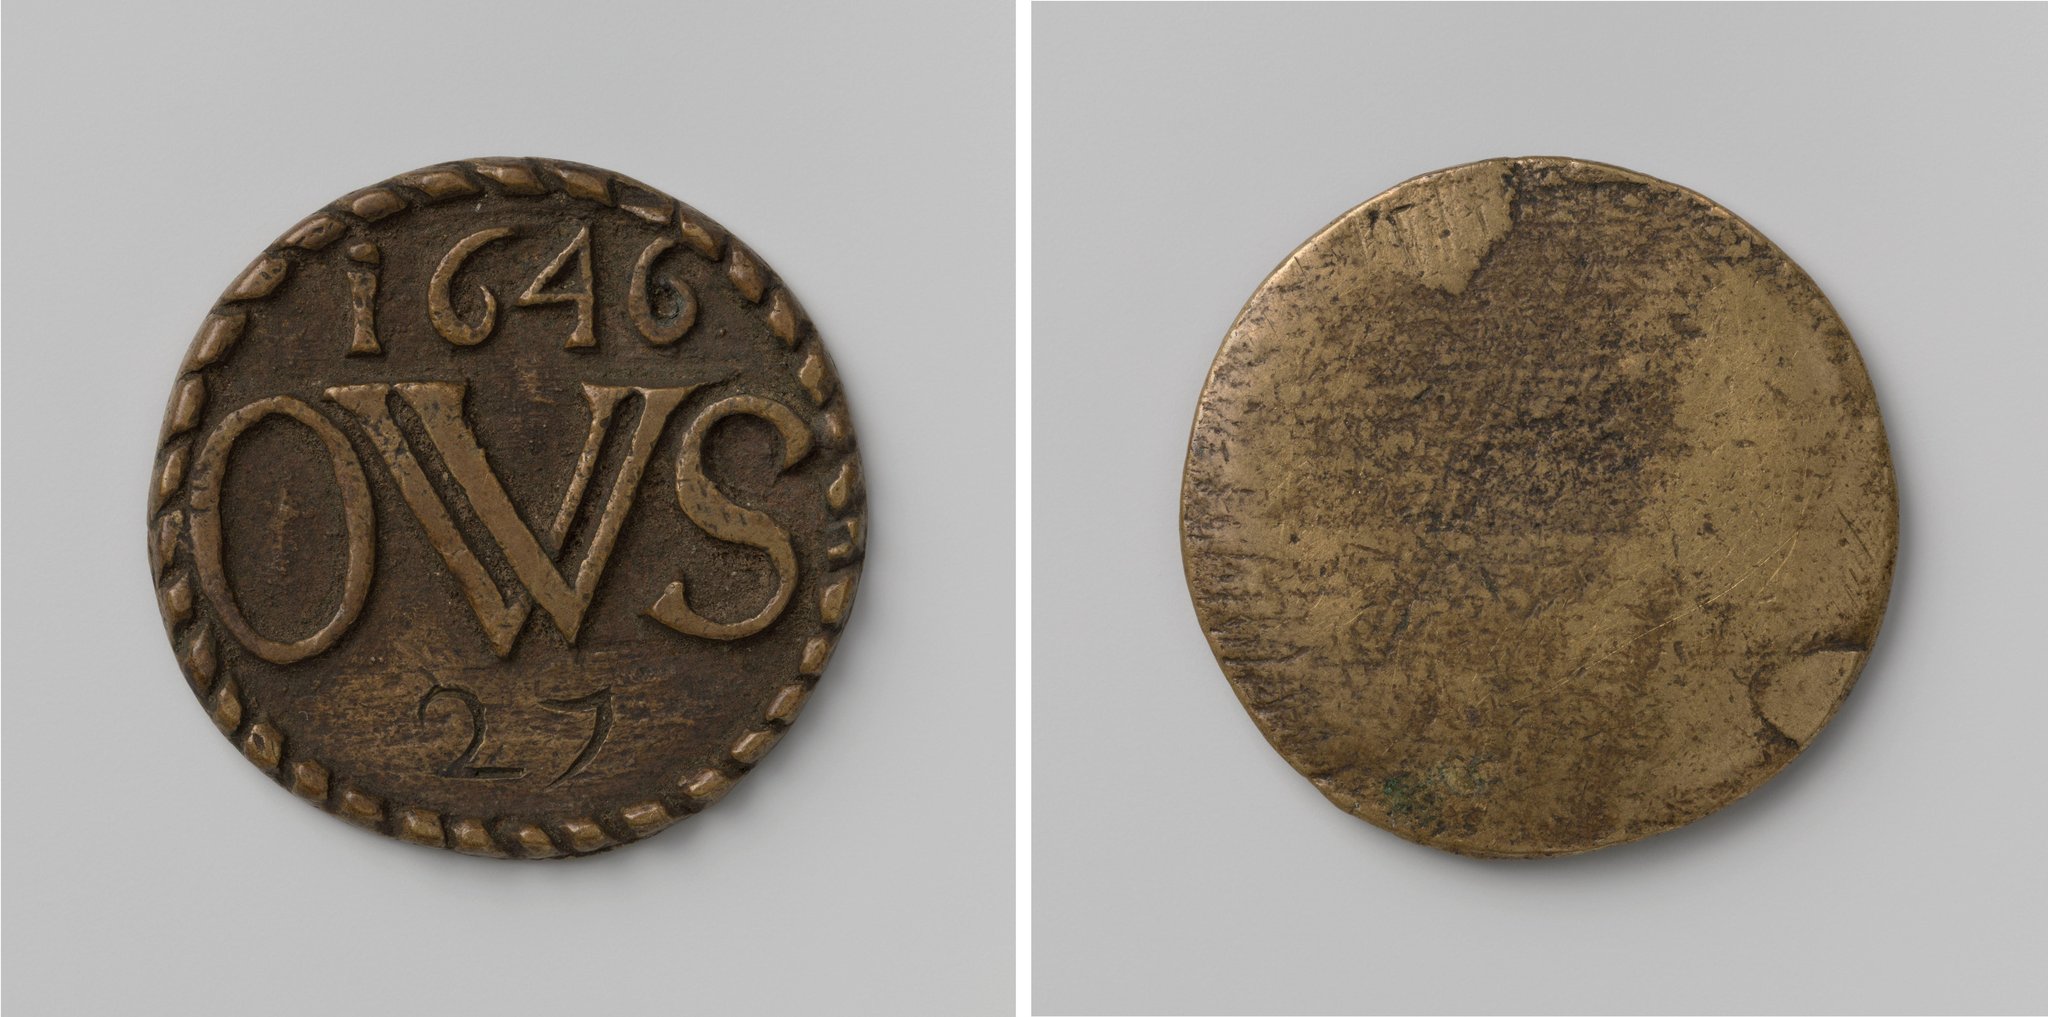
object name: buurtpenning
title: Oude West Sijde, Den Haag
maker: Anonymous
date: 1646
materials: bronze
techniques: striking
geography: netherlands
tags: the hague